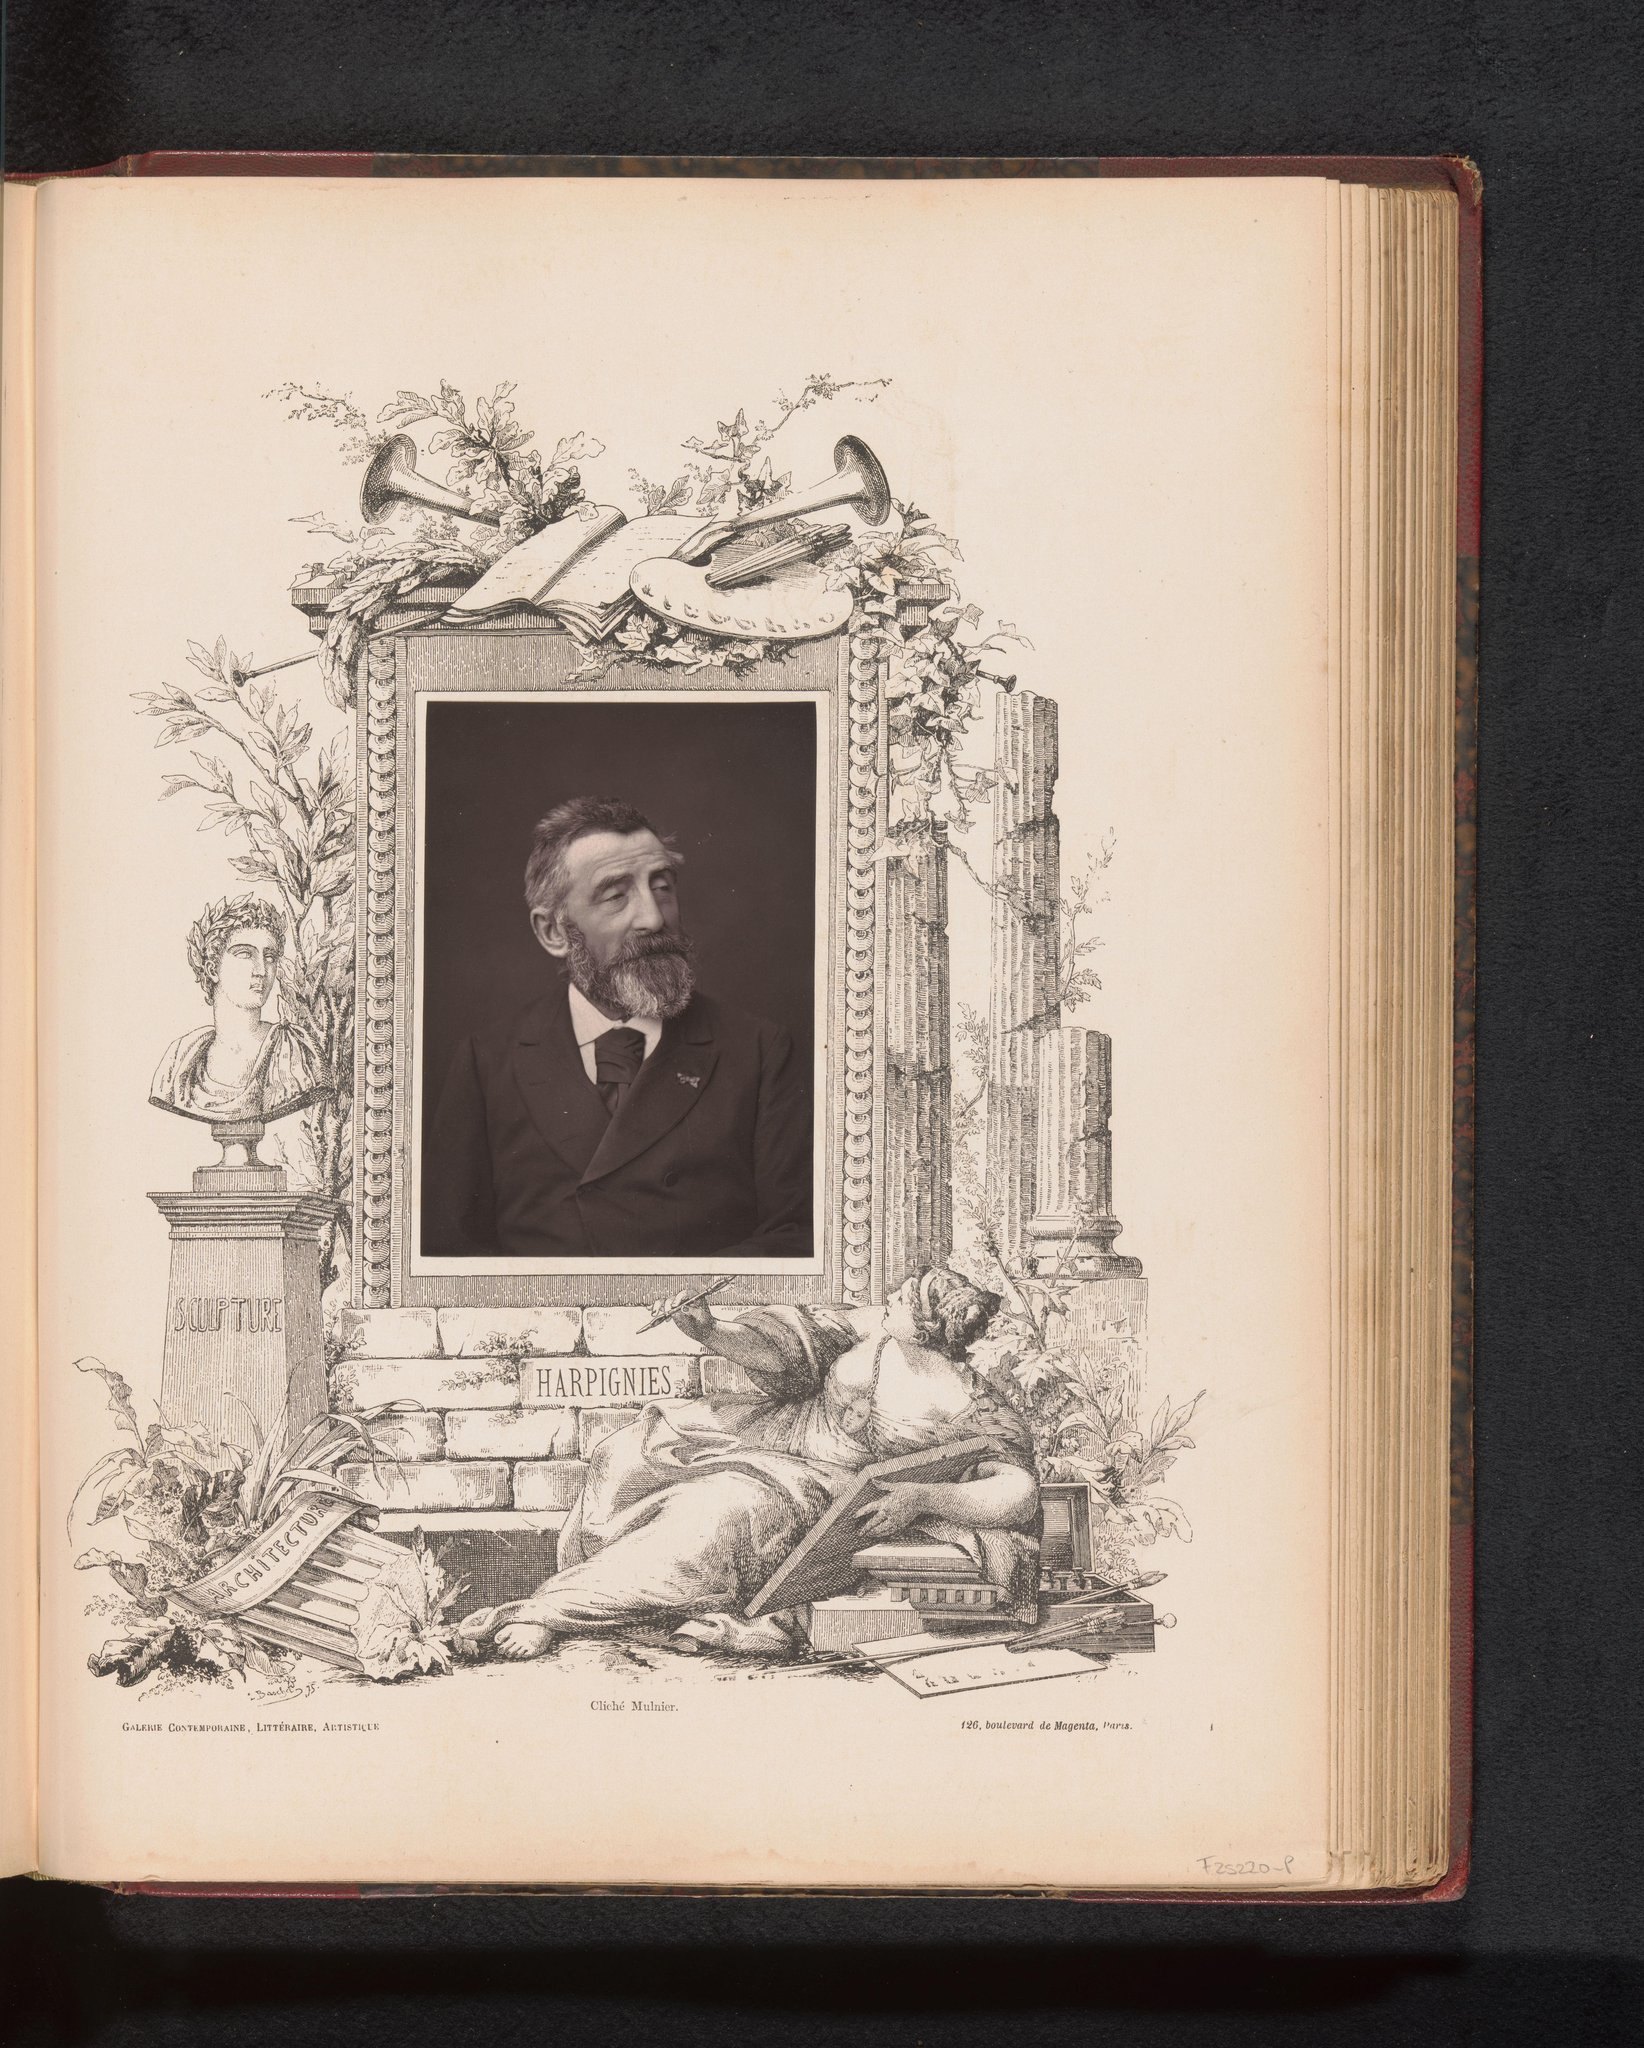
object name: page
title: Harpignies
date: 1878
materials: paper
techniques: printing block, woodburytype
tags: print maker, draughtsman, henri joseph harpignies, portrait, self-portrait of sculptor, historical persons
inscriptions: inscription: ‘Galerie Contemporaine, Littérarie, Artistique’